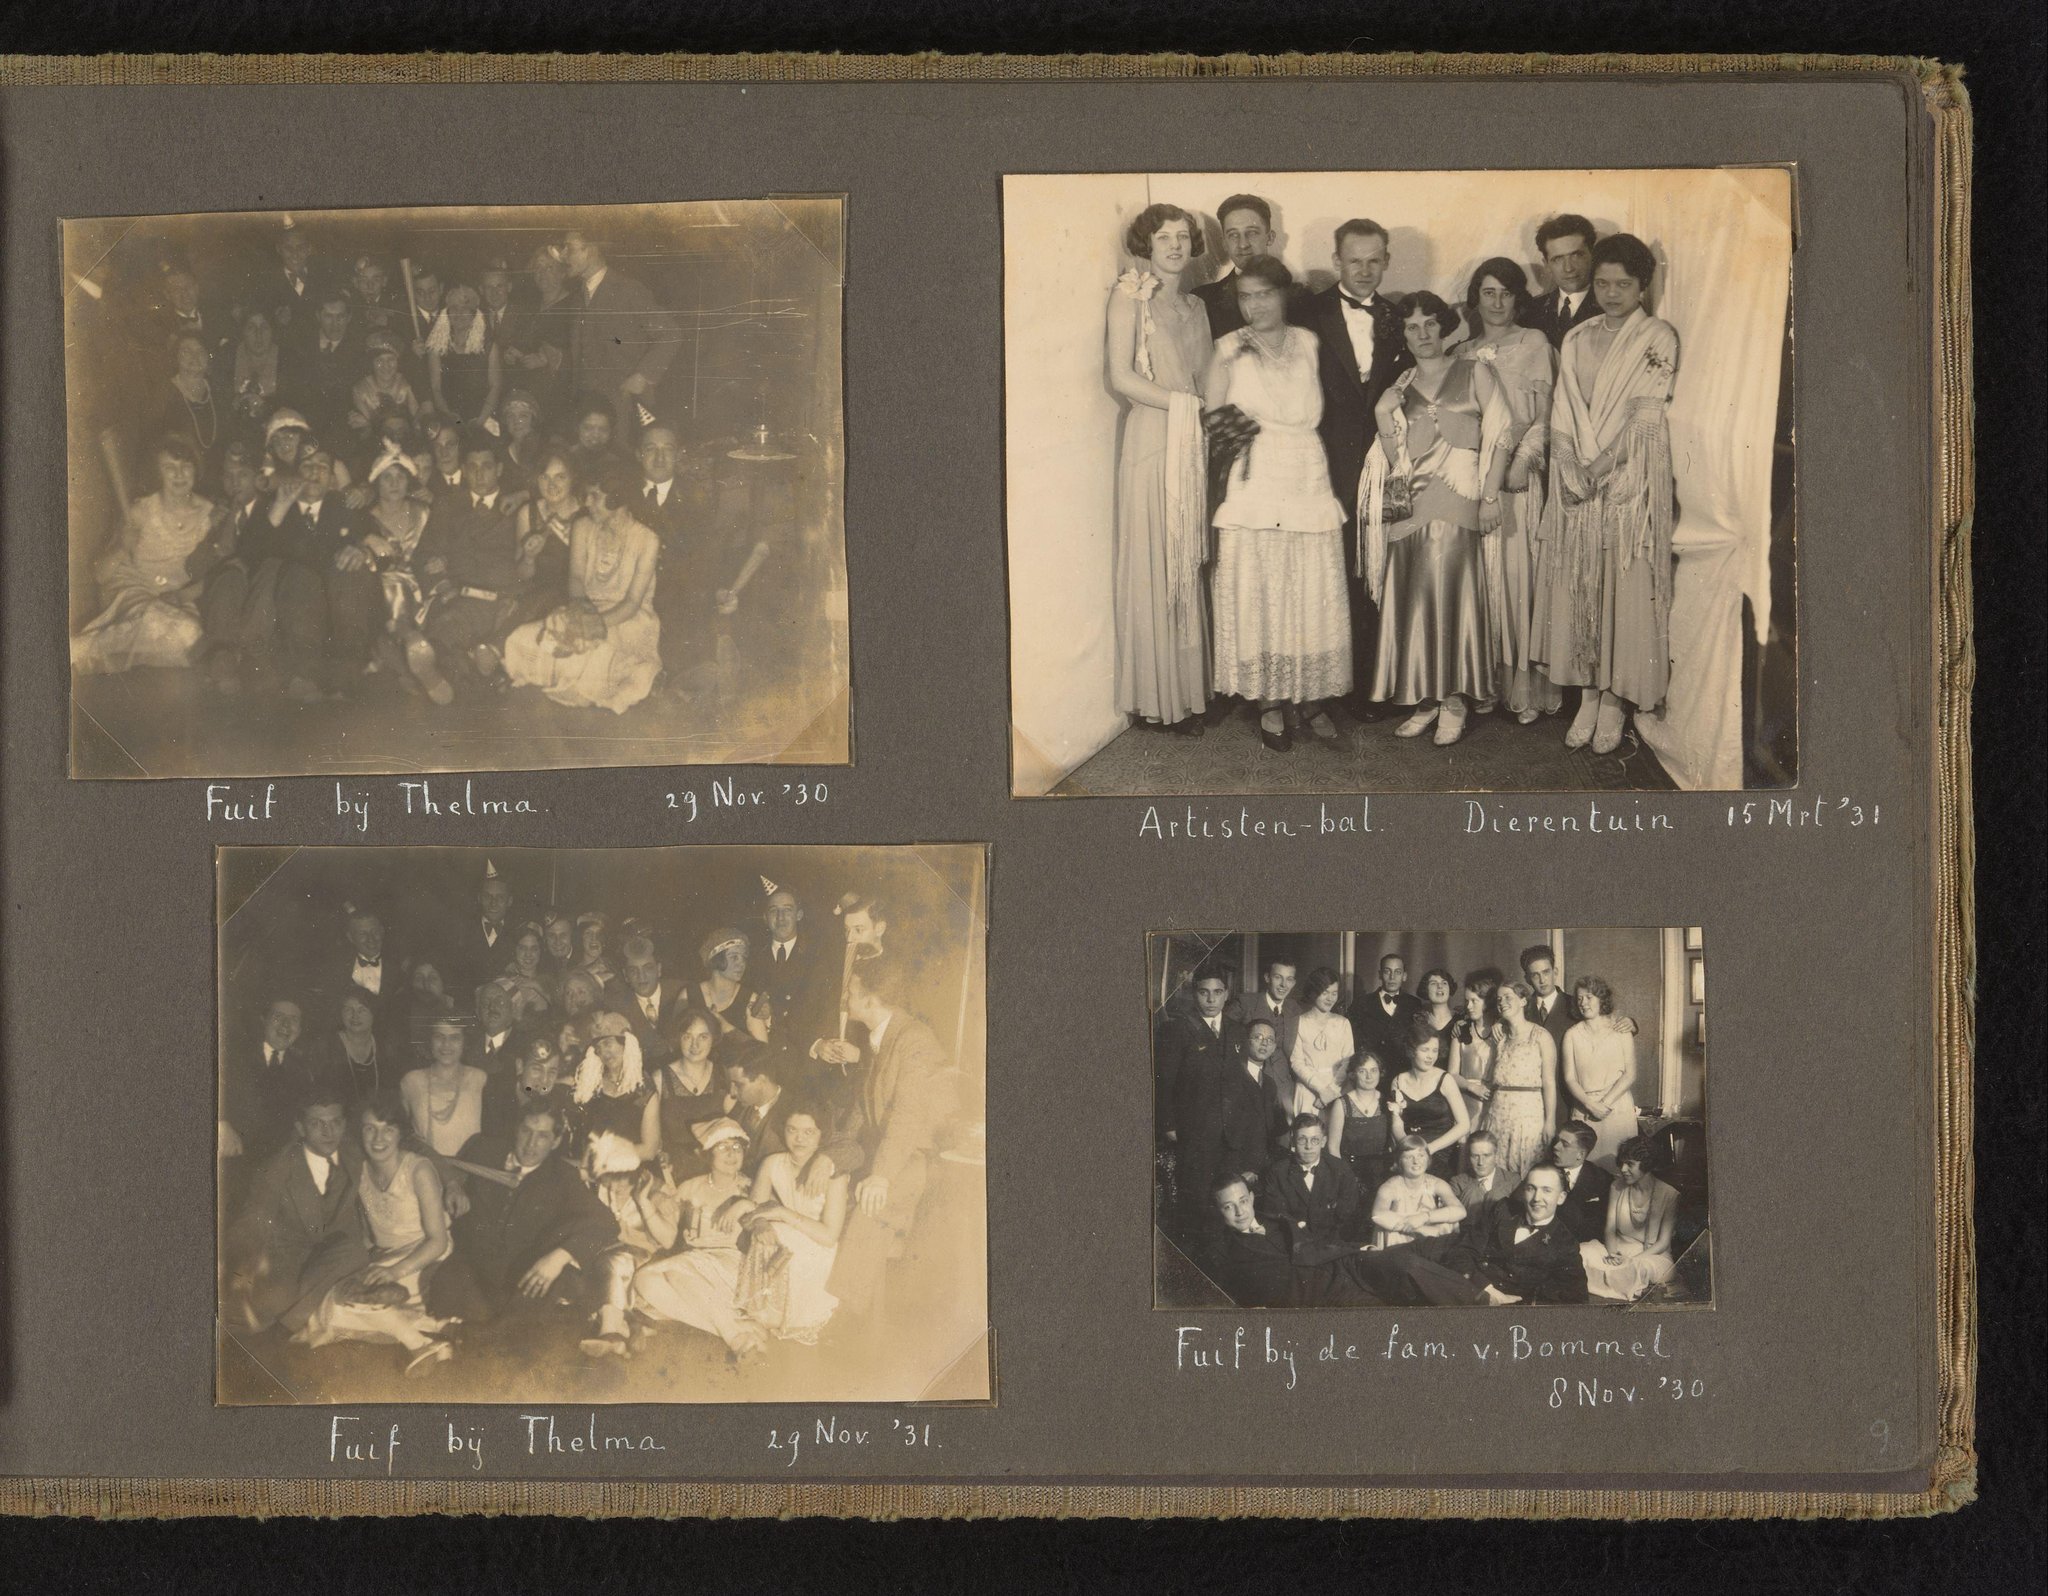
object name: photograph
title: Fuifen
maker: Anonymous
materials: cardboard, photographic support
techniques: gelatin silver print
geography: netherlands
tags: reception, cocktail party, ball, formal dance, student life, netherlands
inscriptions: inscription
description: Albumblad met vier foto's van groepen feestvierende jonge mensen op fuifen en een bal bij vrienden en in de dierentuin, november 1930 - maart 1931. Onderdeel van fotoalbum 'Studentenalbum Indologen'.